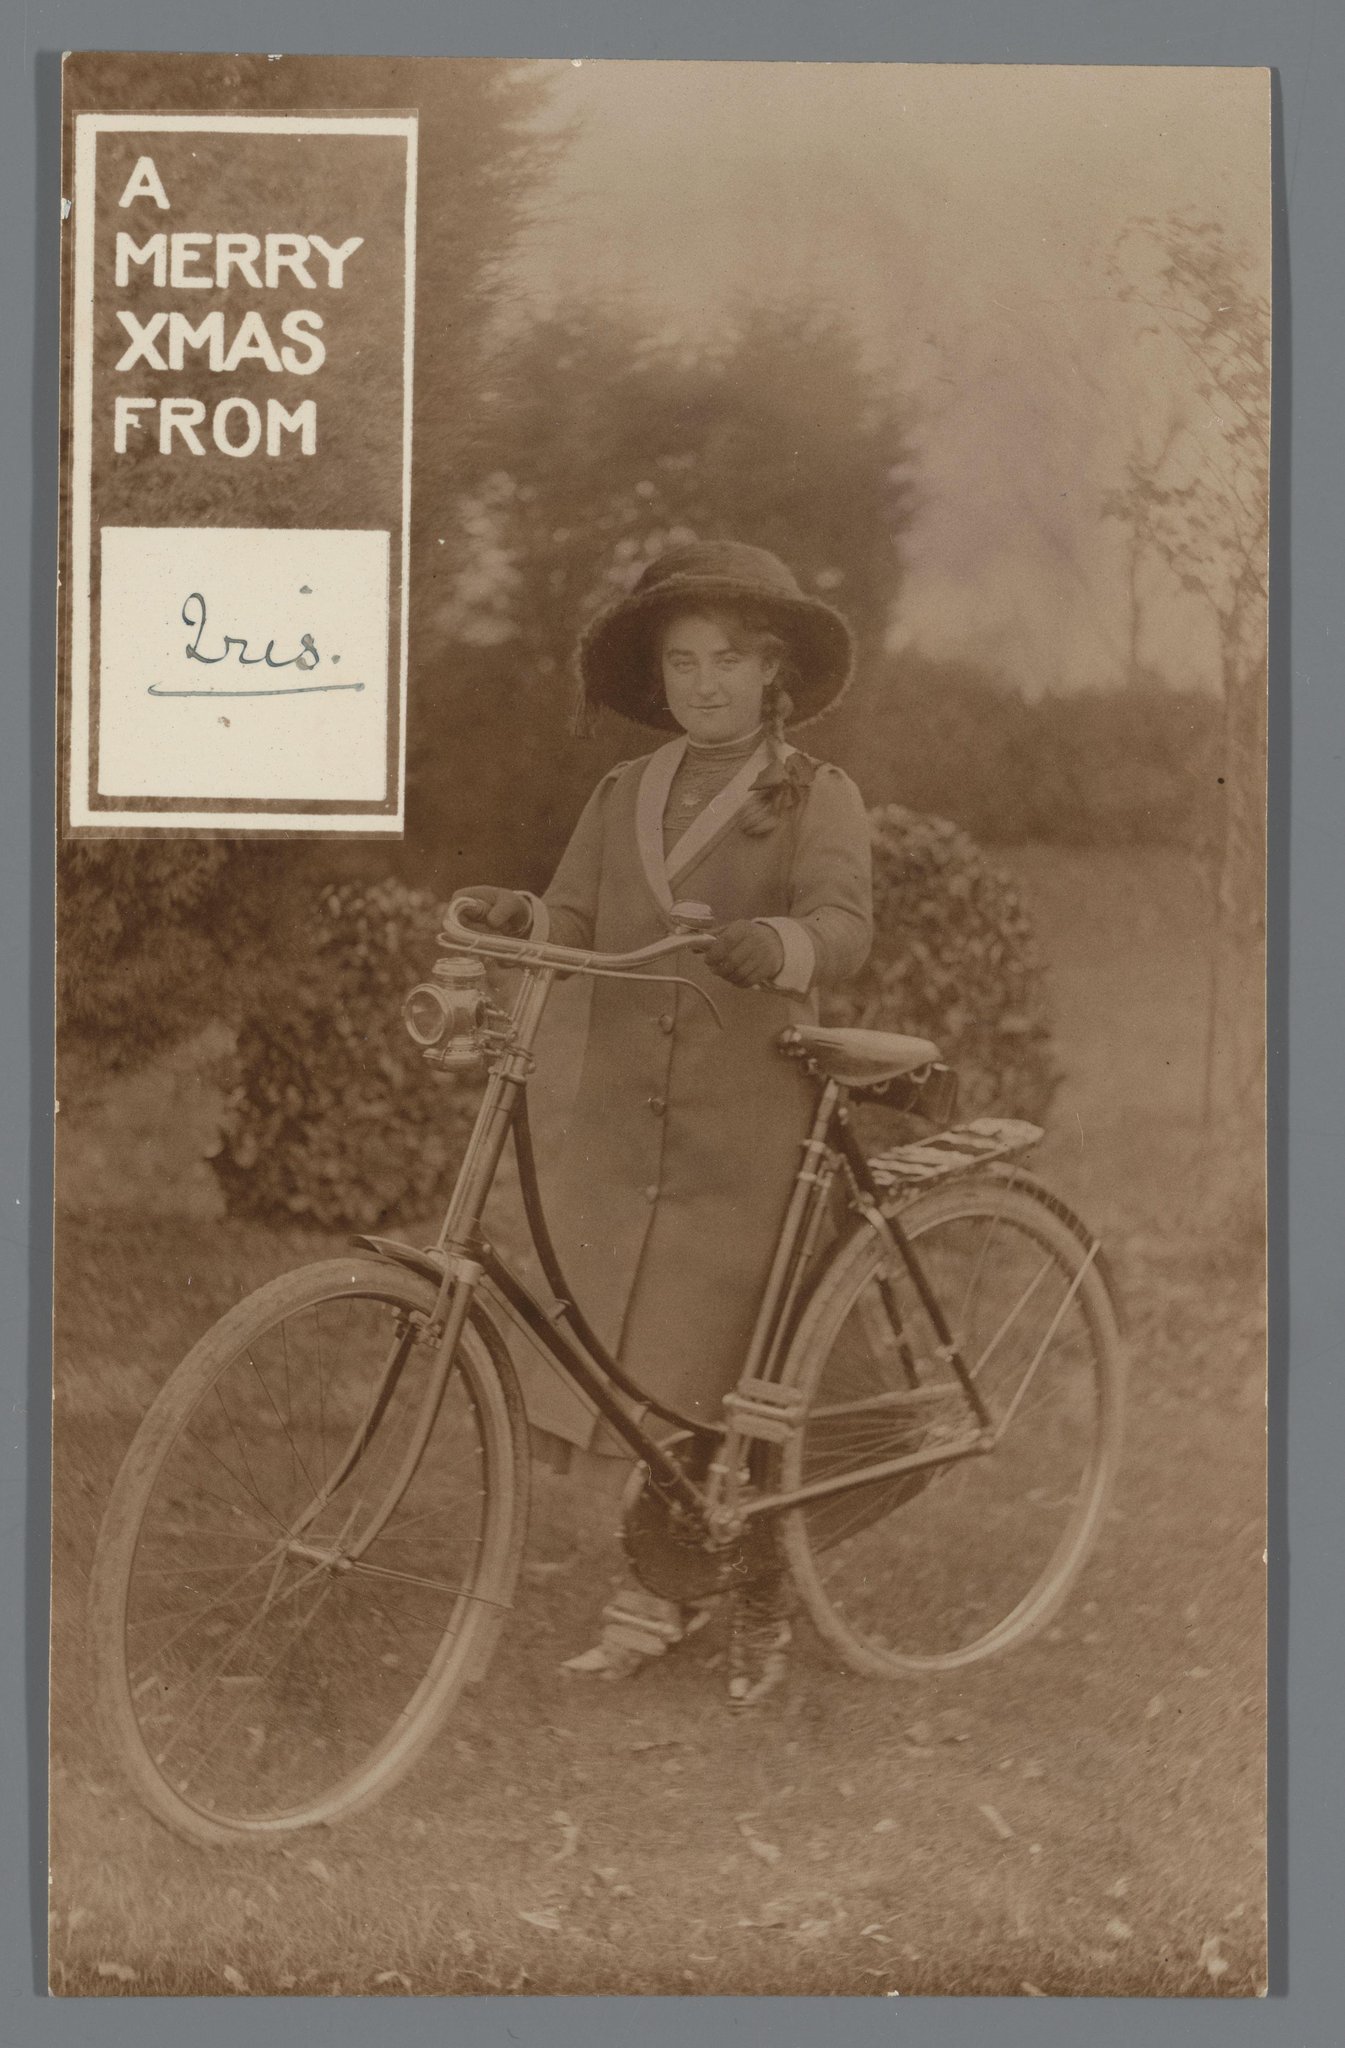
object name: christmas card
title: Kerst- en nieuwjaarswens met een portret van Iris Berry bij een fiets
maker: Anonymous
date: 1910-1930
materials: paper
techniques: gelatin silver print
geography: england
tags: adolescent, young woman, maiden, historical persons - bb - woman, bicycle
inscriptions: inscription: ‘The Red Lion/ Stone Cross/ Pevensey/ Dear Ena/ just a/ card to wish you/ a very happy Christmas/ and bright new year./ I remain/ your loving friend,/ Iris Berry.’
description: Portret van Iris Berry bij een fiets in een park, met de tekst 'A merry Xmas from Iris', geadresseerd aan Ena.